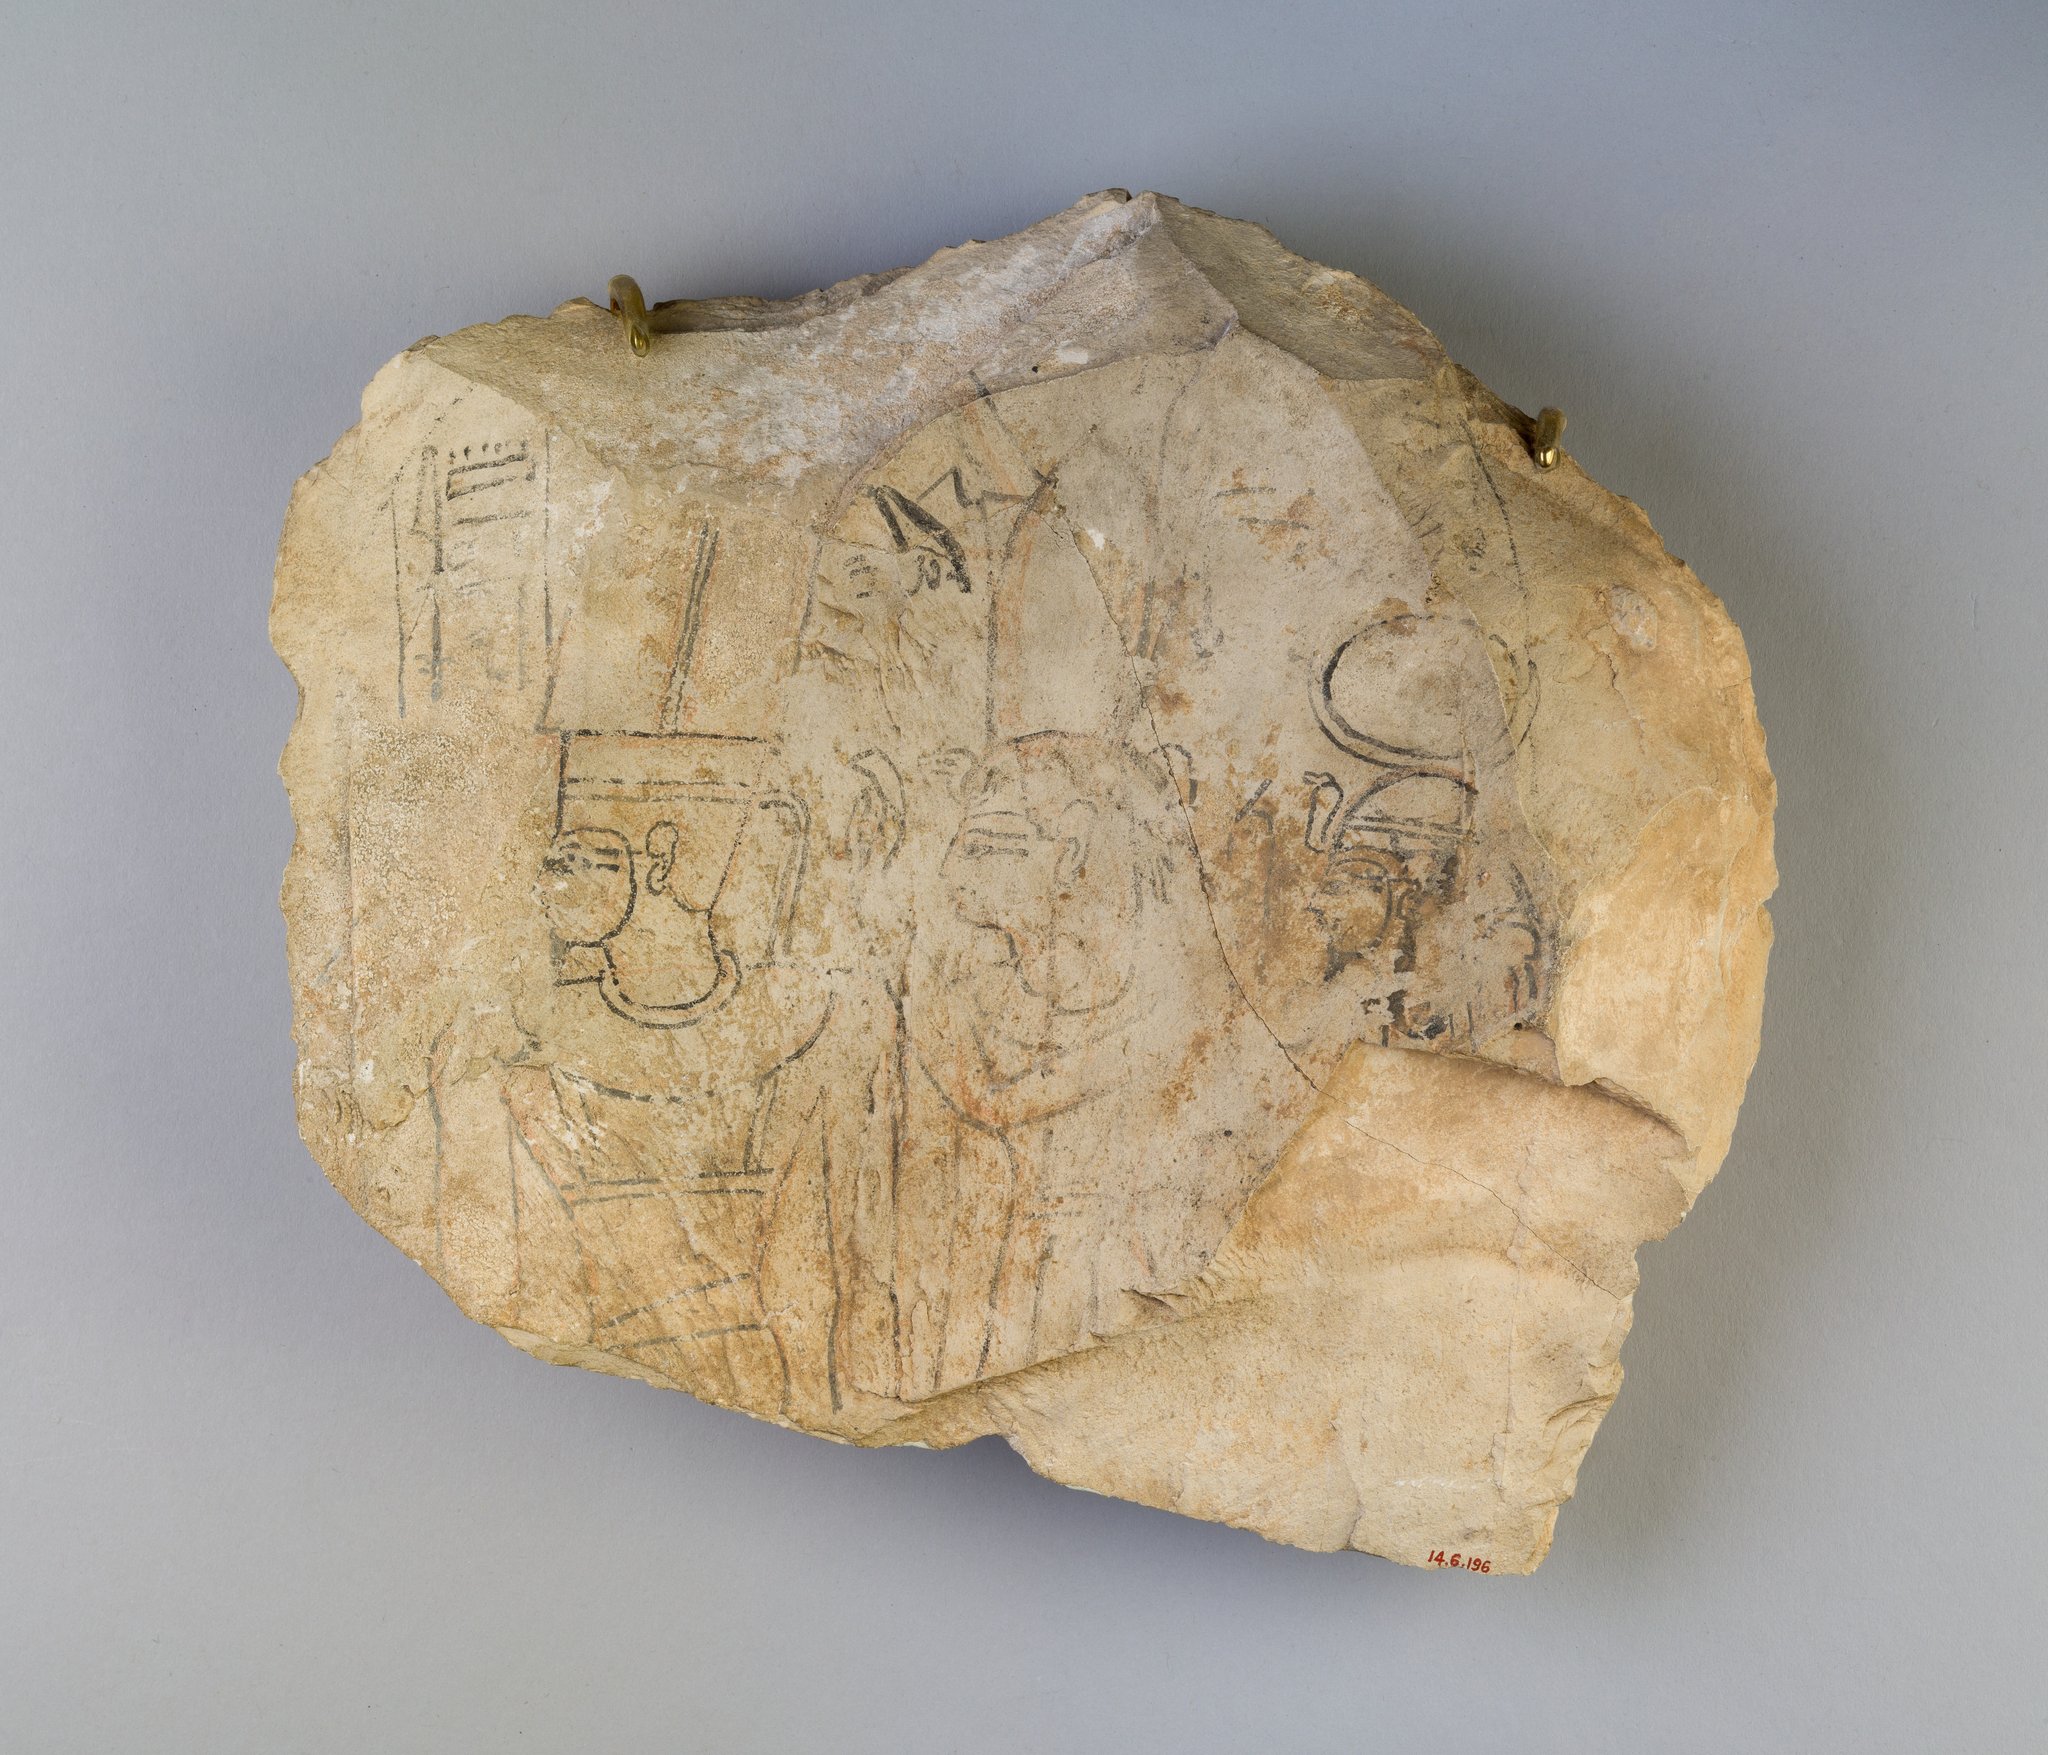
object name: ostracon, hieroglyph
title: Ostracon with Line Drawing of Theban Triad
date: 1295-1070 BCE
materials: ink, limestone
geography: egypt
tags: human figures